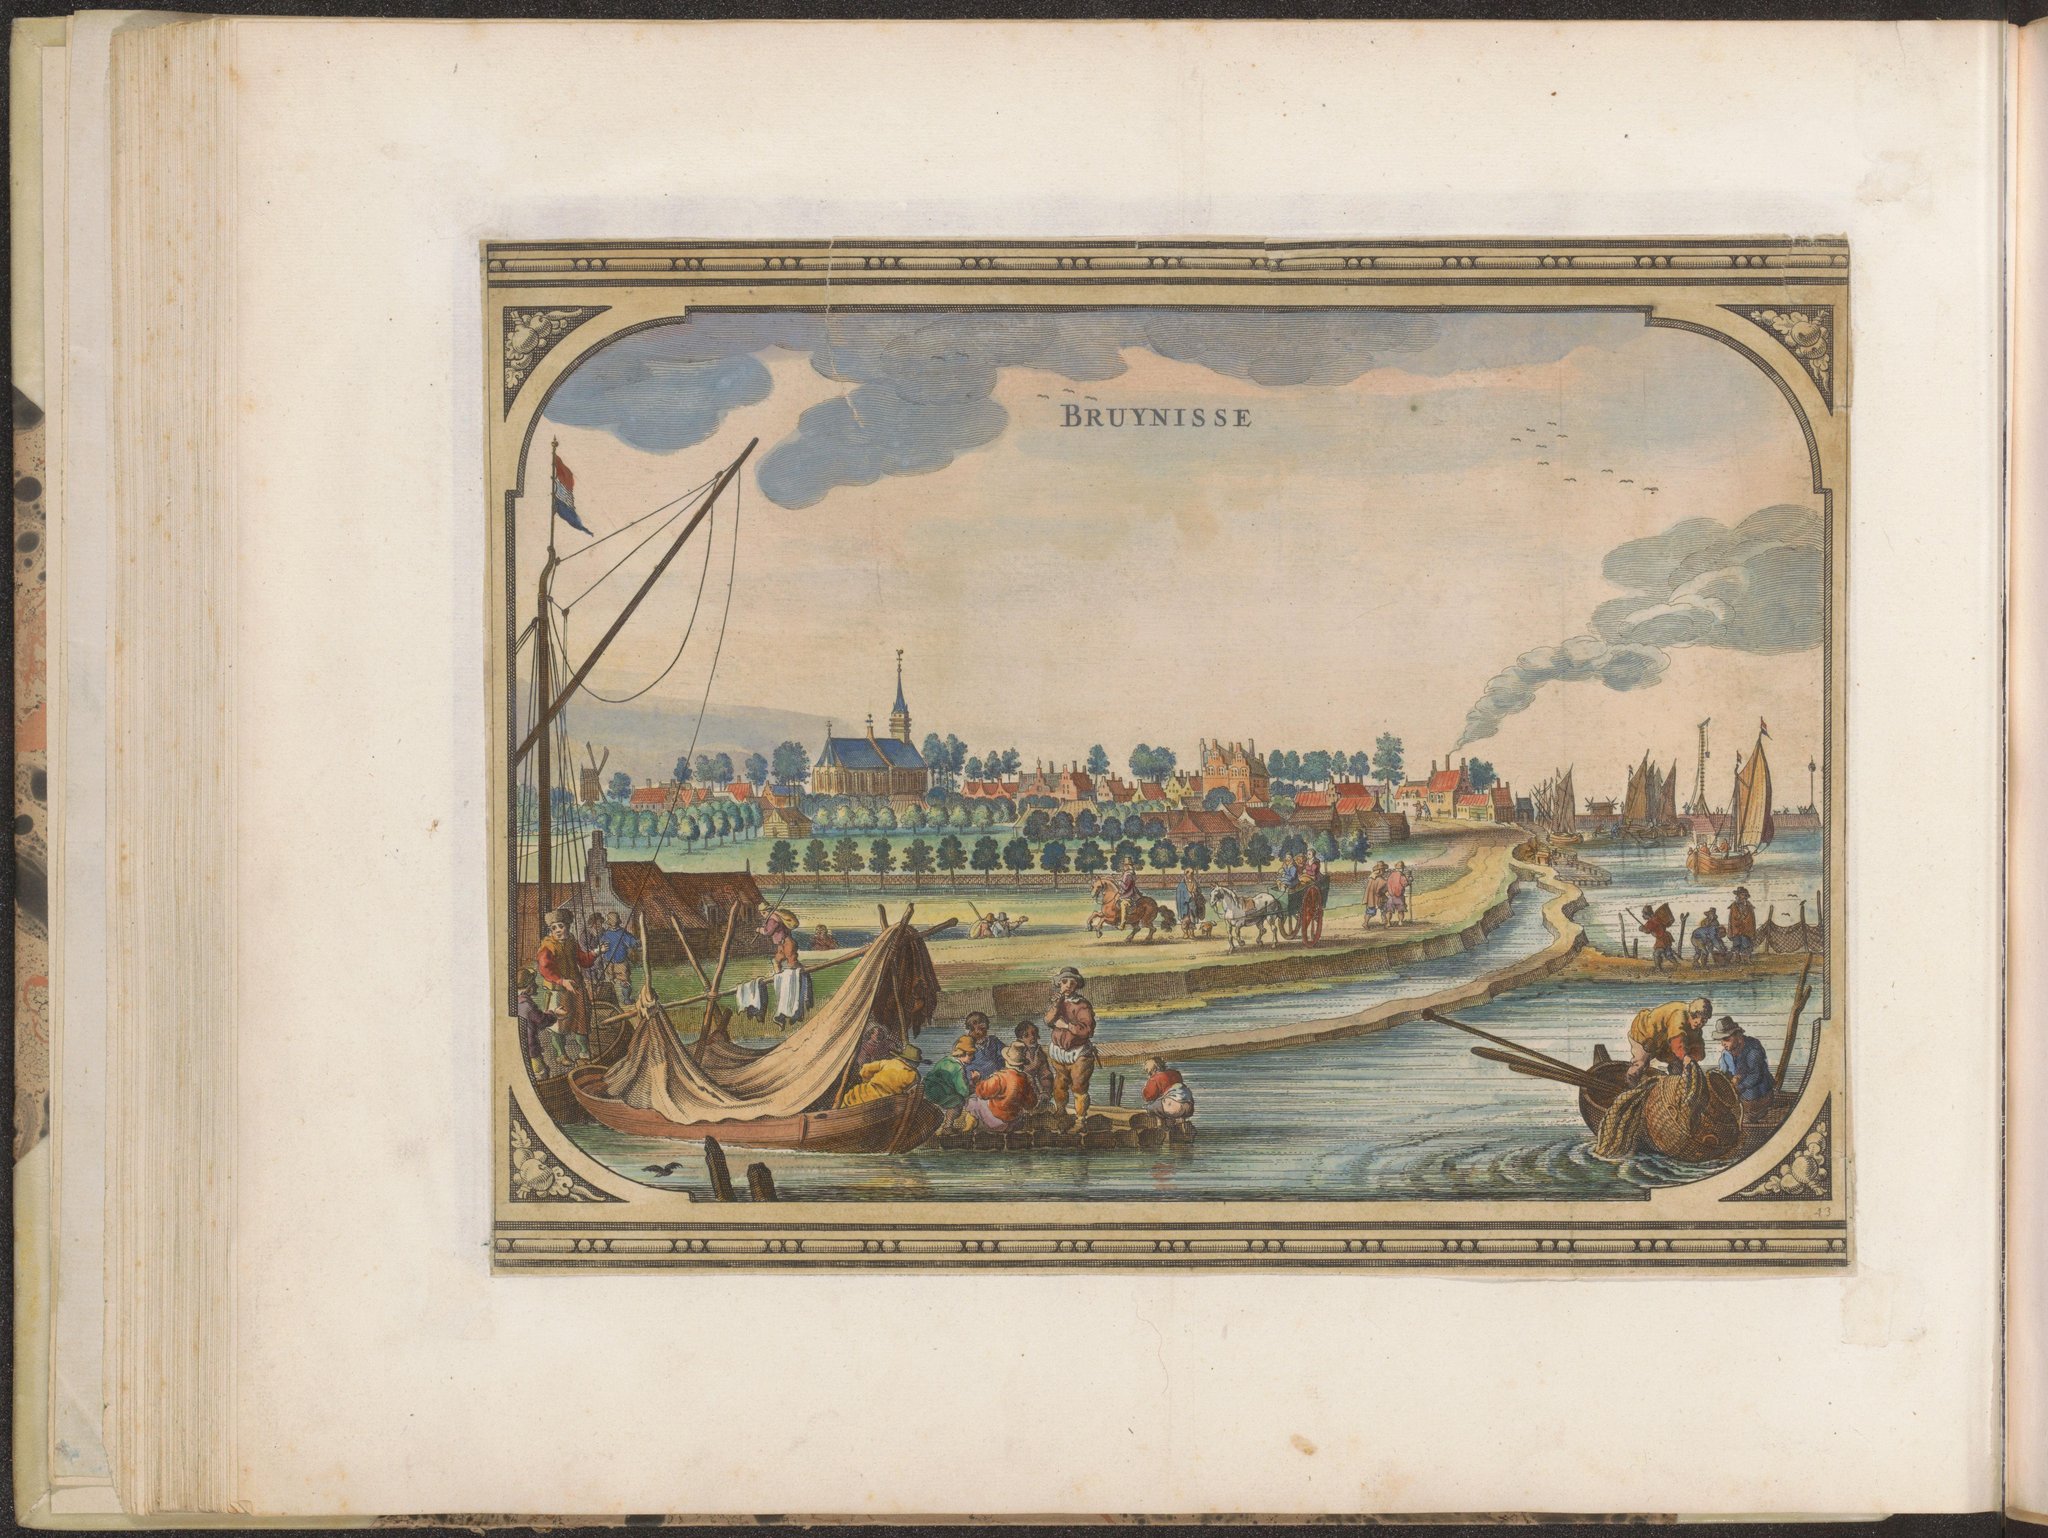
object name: print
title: Gezicht op Bruinisse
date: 1662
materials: paper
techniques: etching, hand coloring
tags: city-view, and landscape with man-made constructions, pipe ~ tobacco, fisherman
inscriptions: inscription: ‘43’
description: Gezicht op de stad Bruinisse. Rechts op de voorgrond halen twee mannen een eendenkooi of fuik uit het water. Links bij een boot zit een groep mannen. Eén van de mannen rookt een pijp. De prent maakt deel uit van een album.